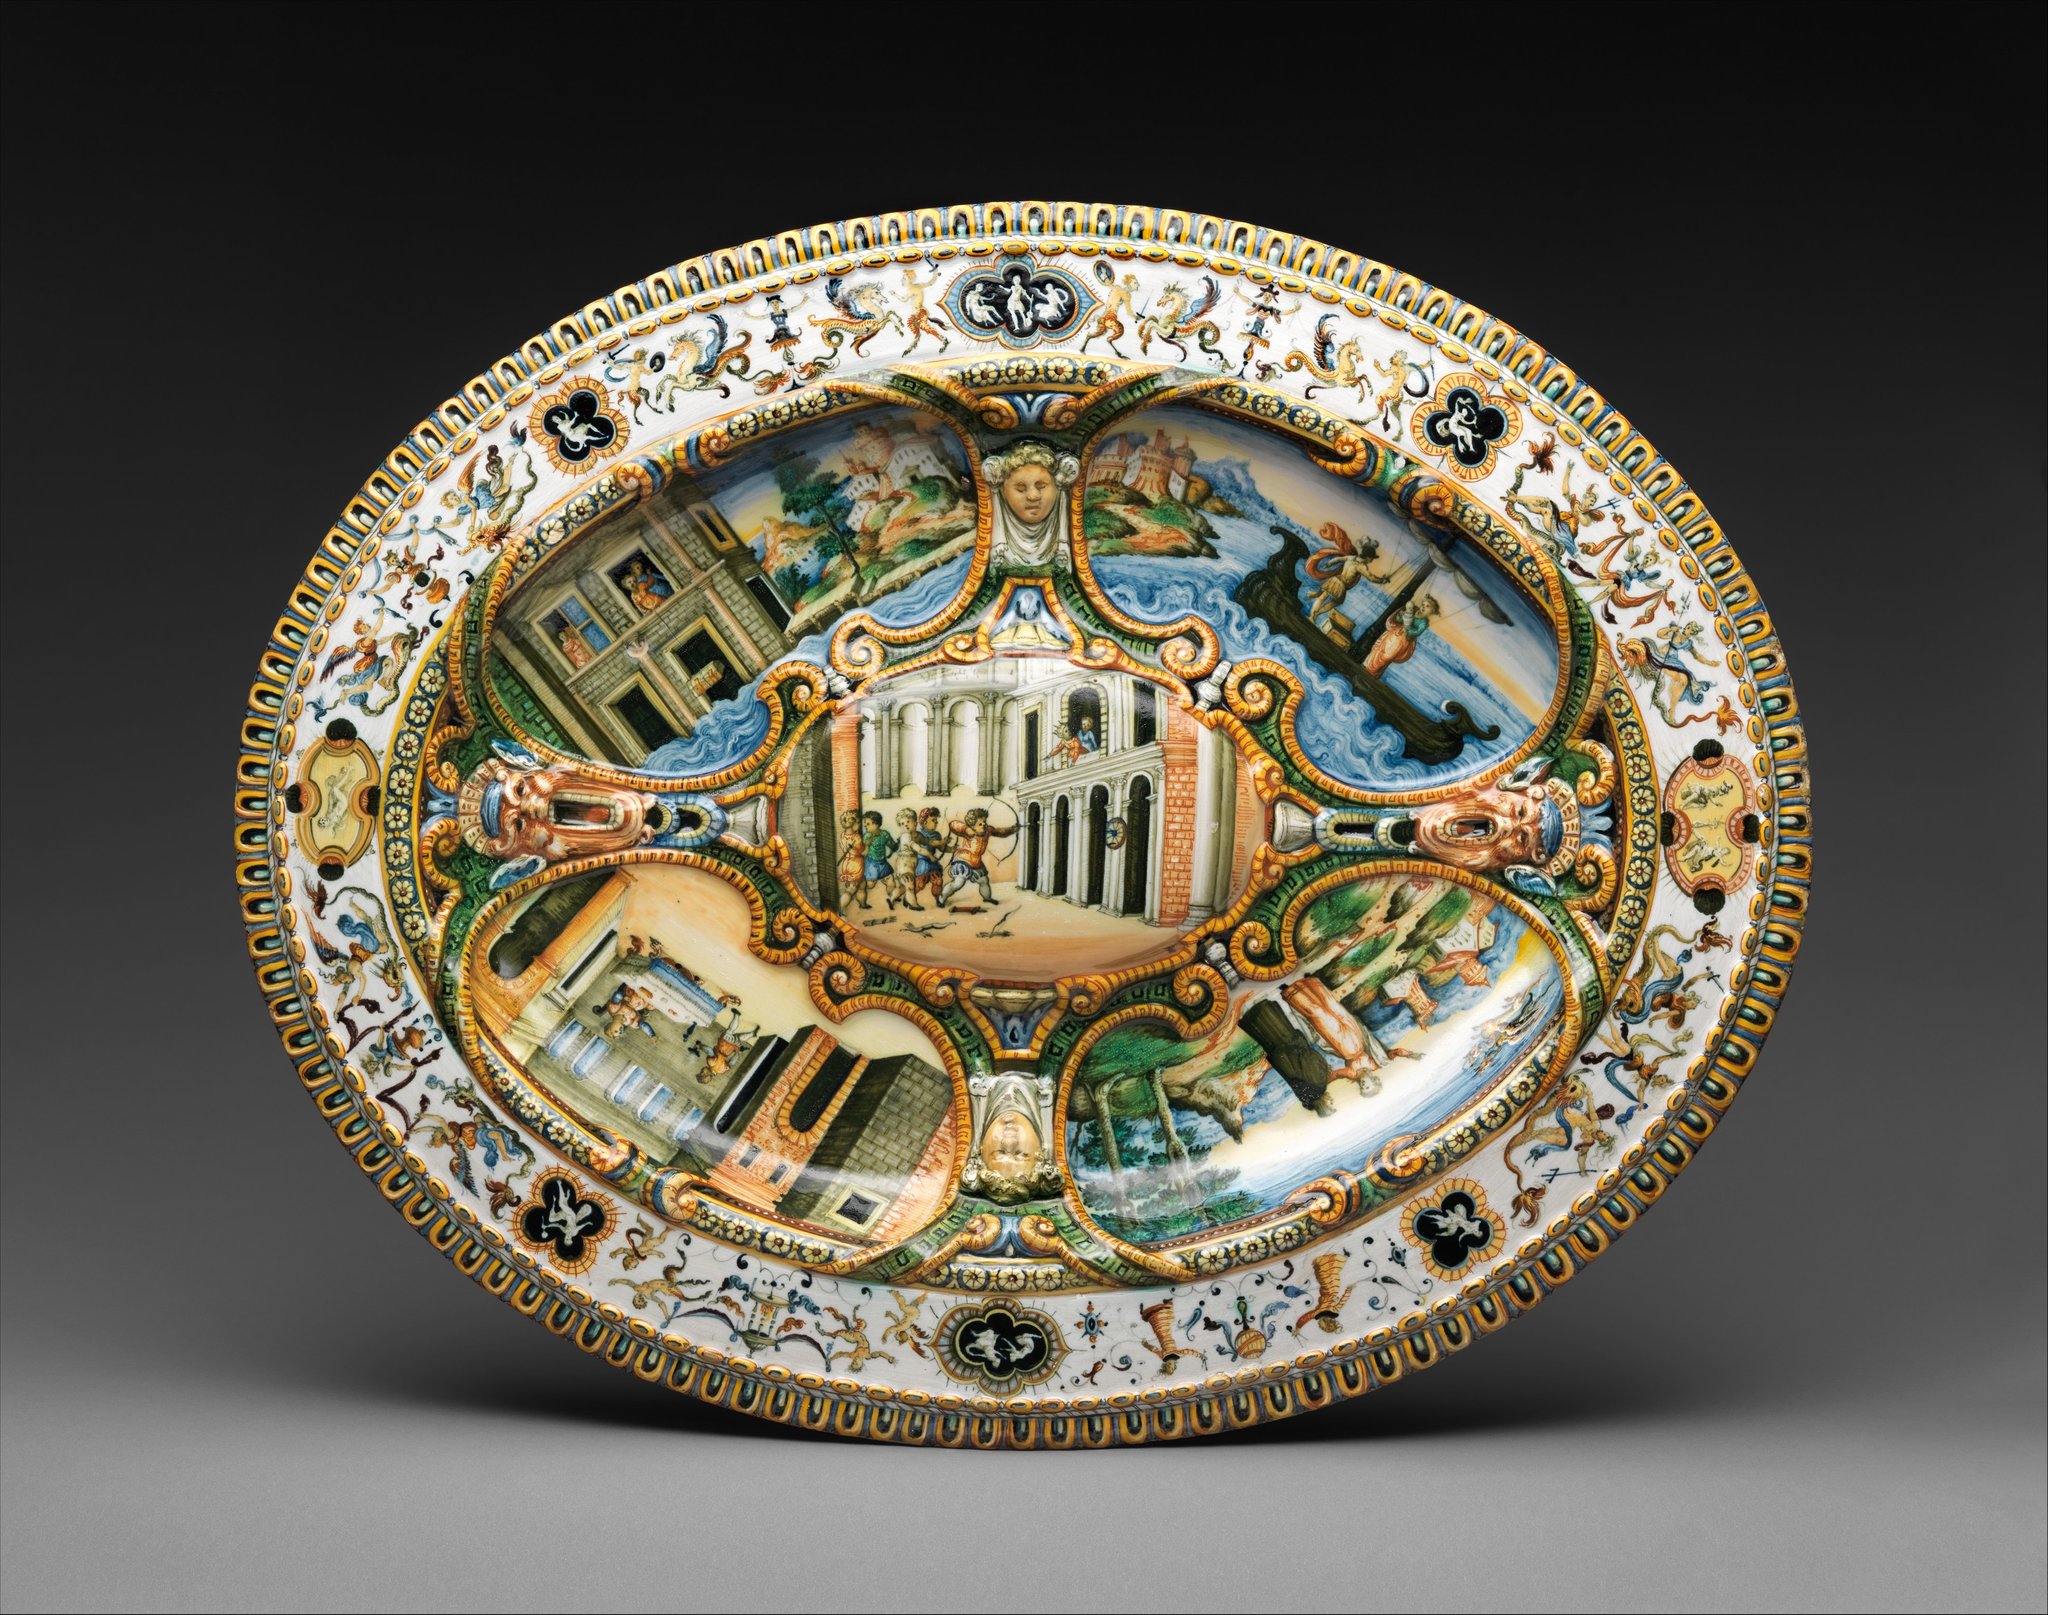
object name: basin or dish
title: Oval basin or dish with subject from Amadis of Gaul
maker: orazio fontana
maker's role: artist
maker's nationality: italian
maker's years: 1505-1576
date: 1559-1564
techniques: maiolica, glazing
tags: buildings,bow and arrow,boys,boats